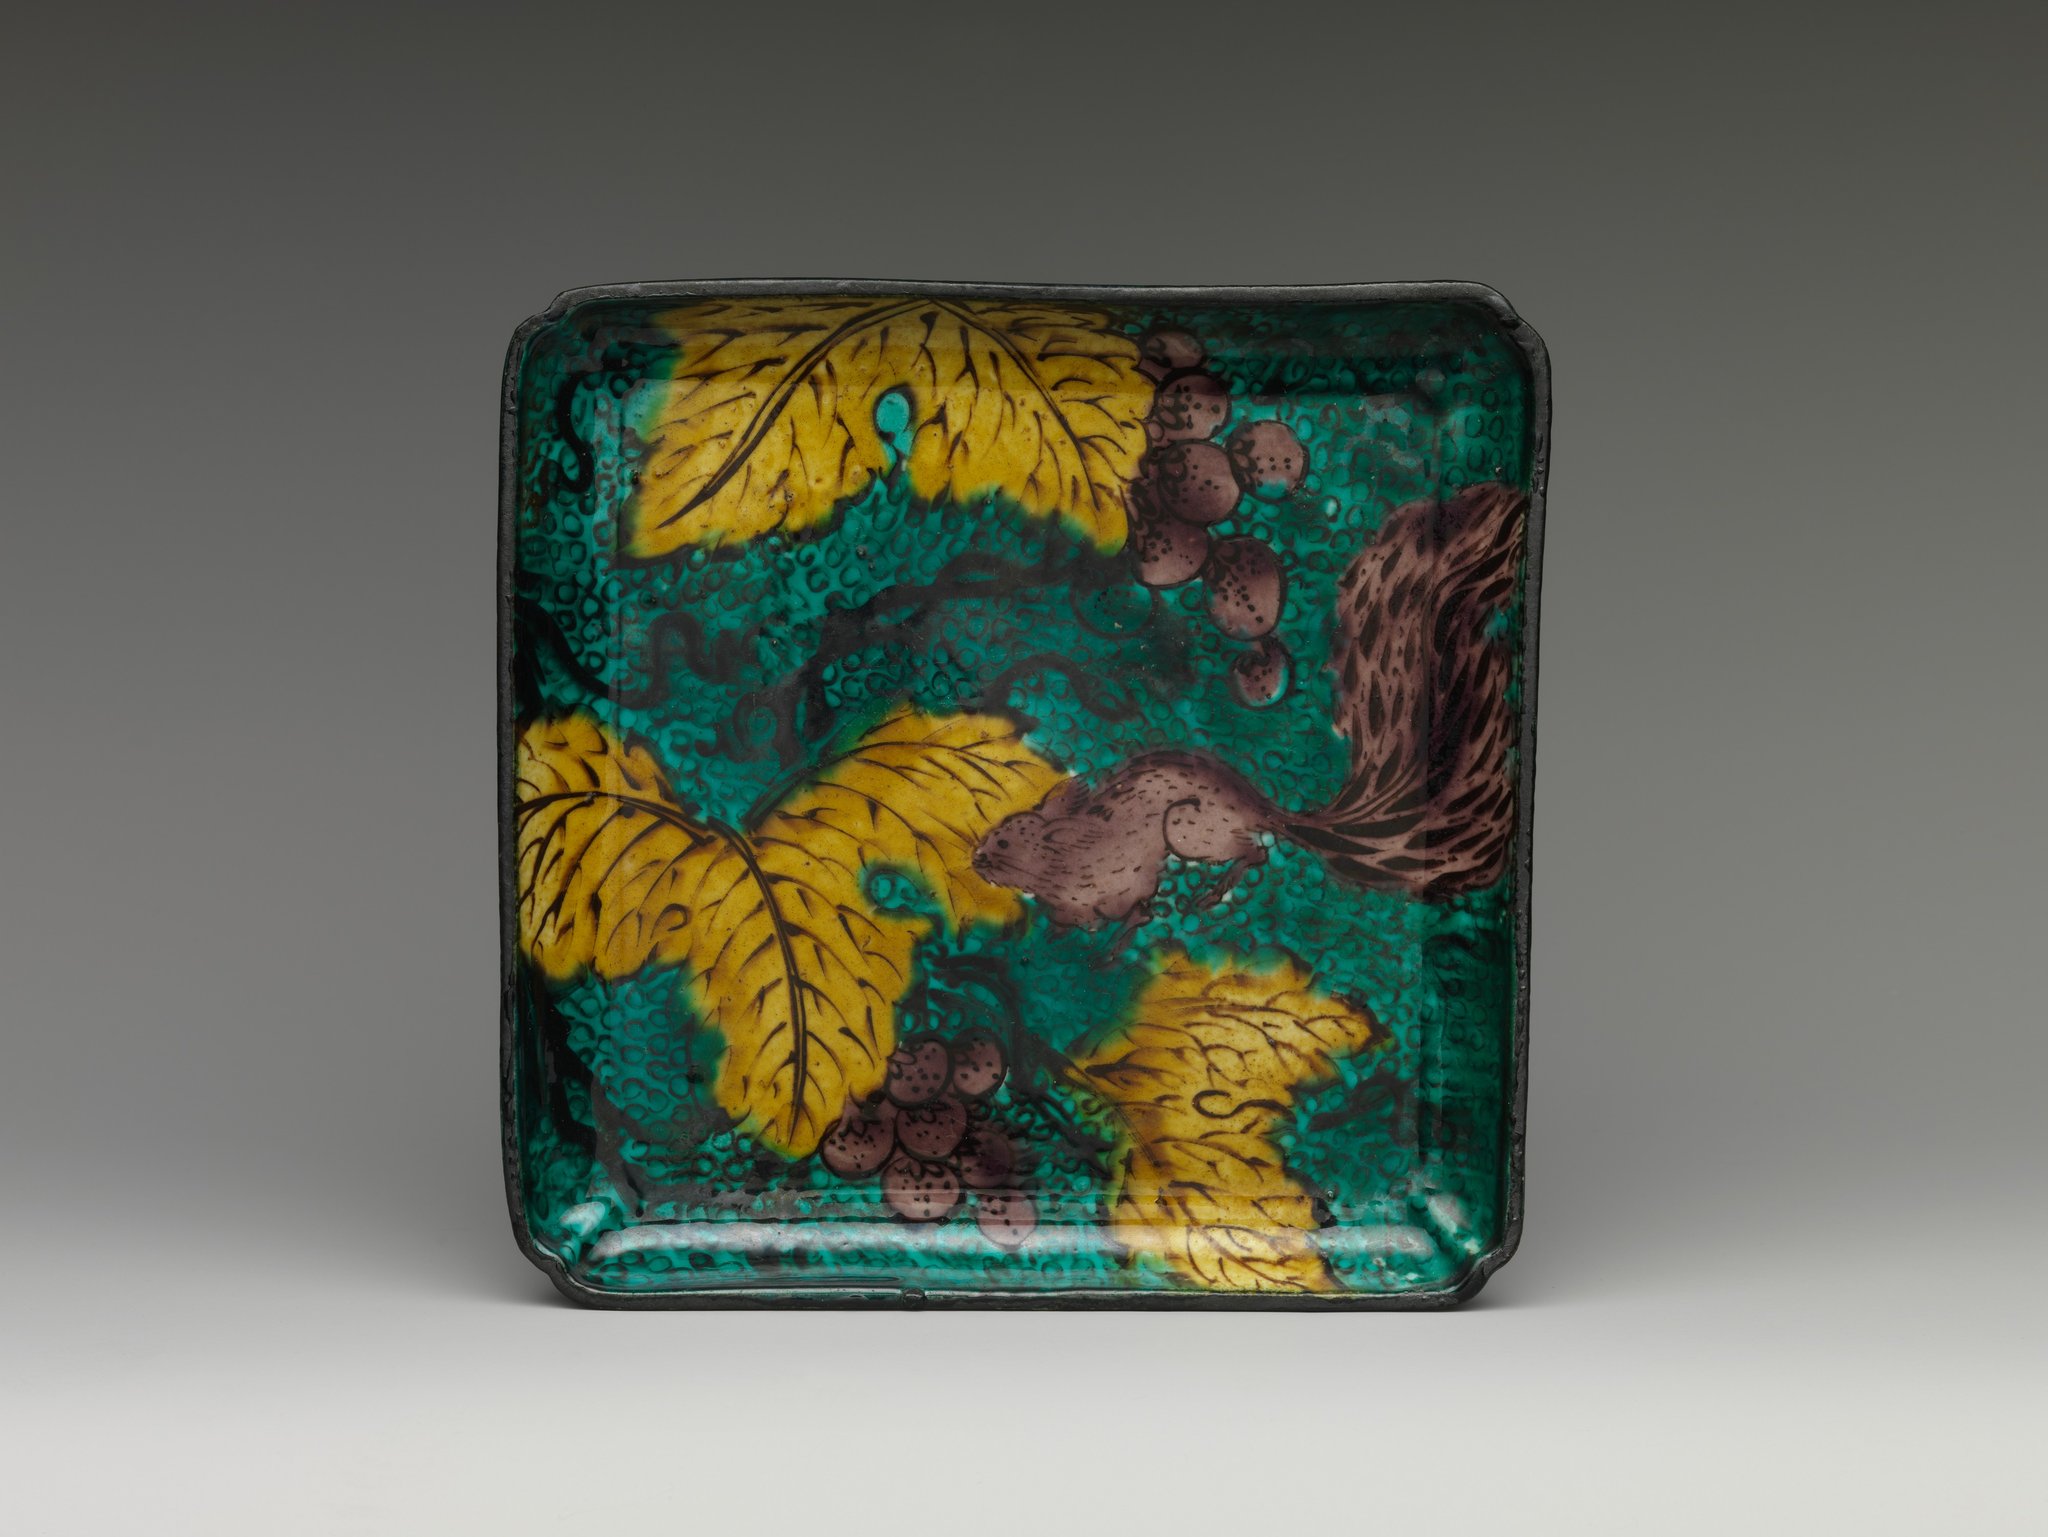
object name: plate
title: Square Plate with Design of Grapes and Squirrel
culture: japanese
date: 1801-1900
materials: enamel, stoneware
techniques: overglaze, polychrome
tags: grapes,squirrels,leaves